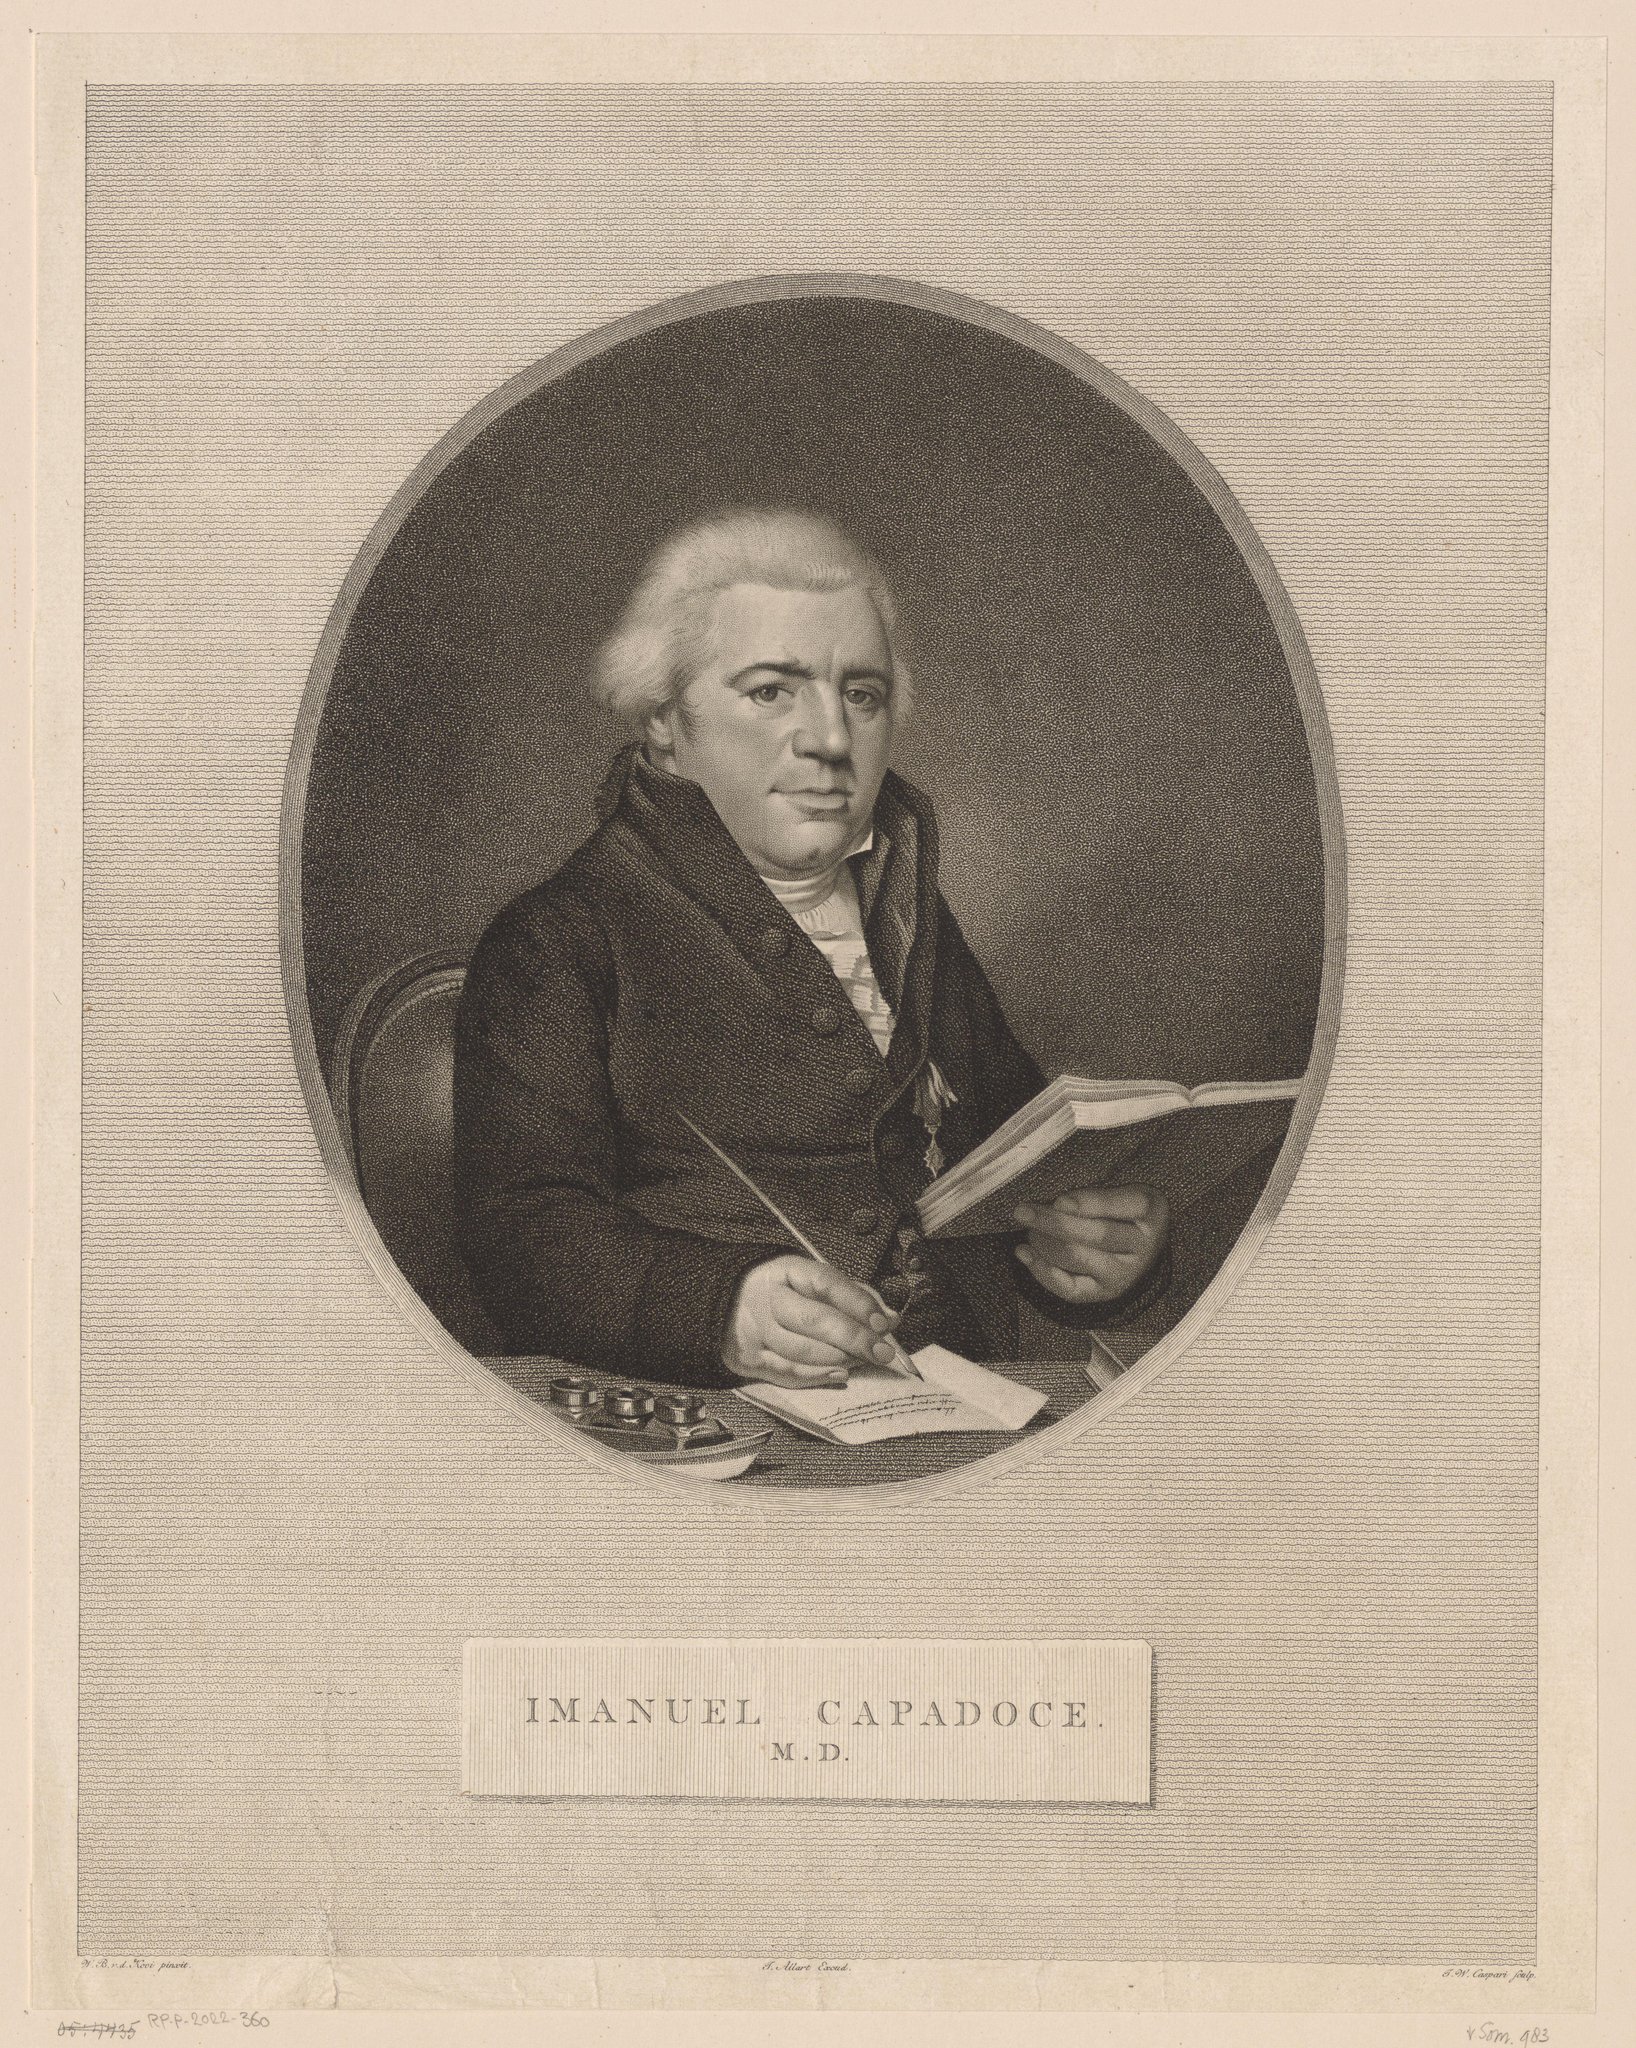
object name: print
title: Portret van Immanuel Capadose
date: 1789-1816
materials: paper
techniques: etching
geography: amsterdam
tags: amsterdam, historical persons